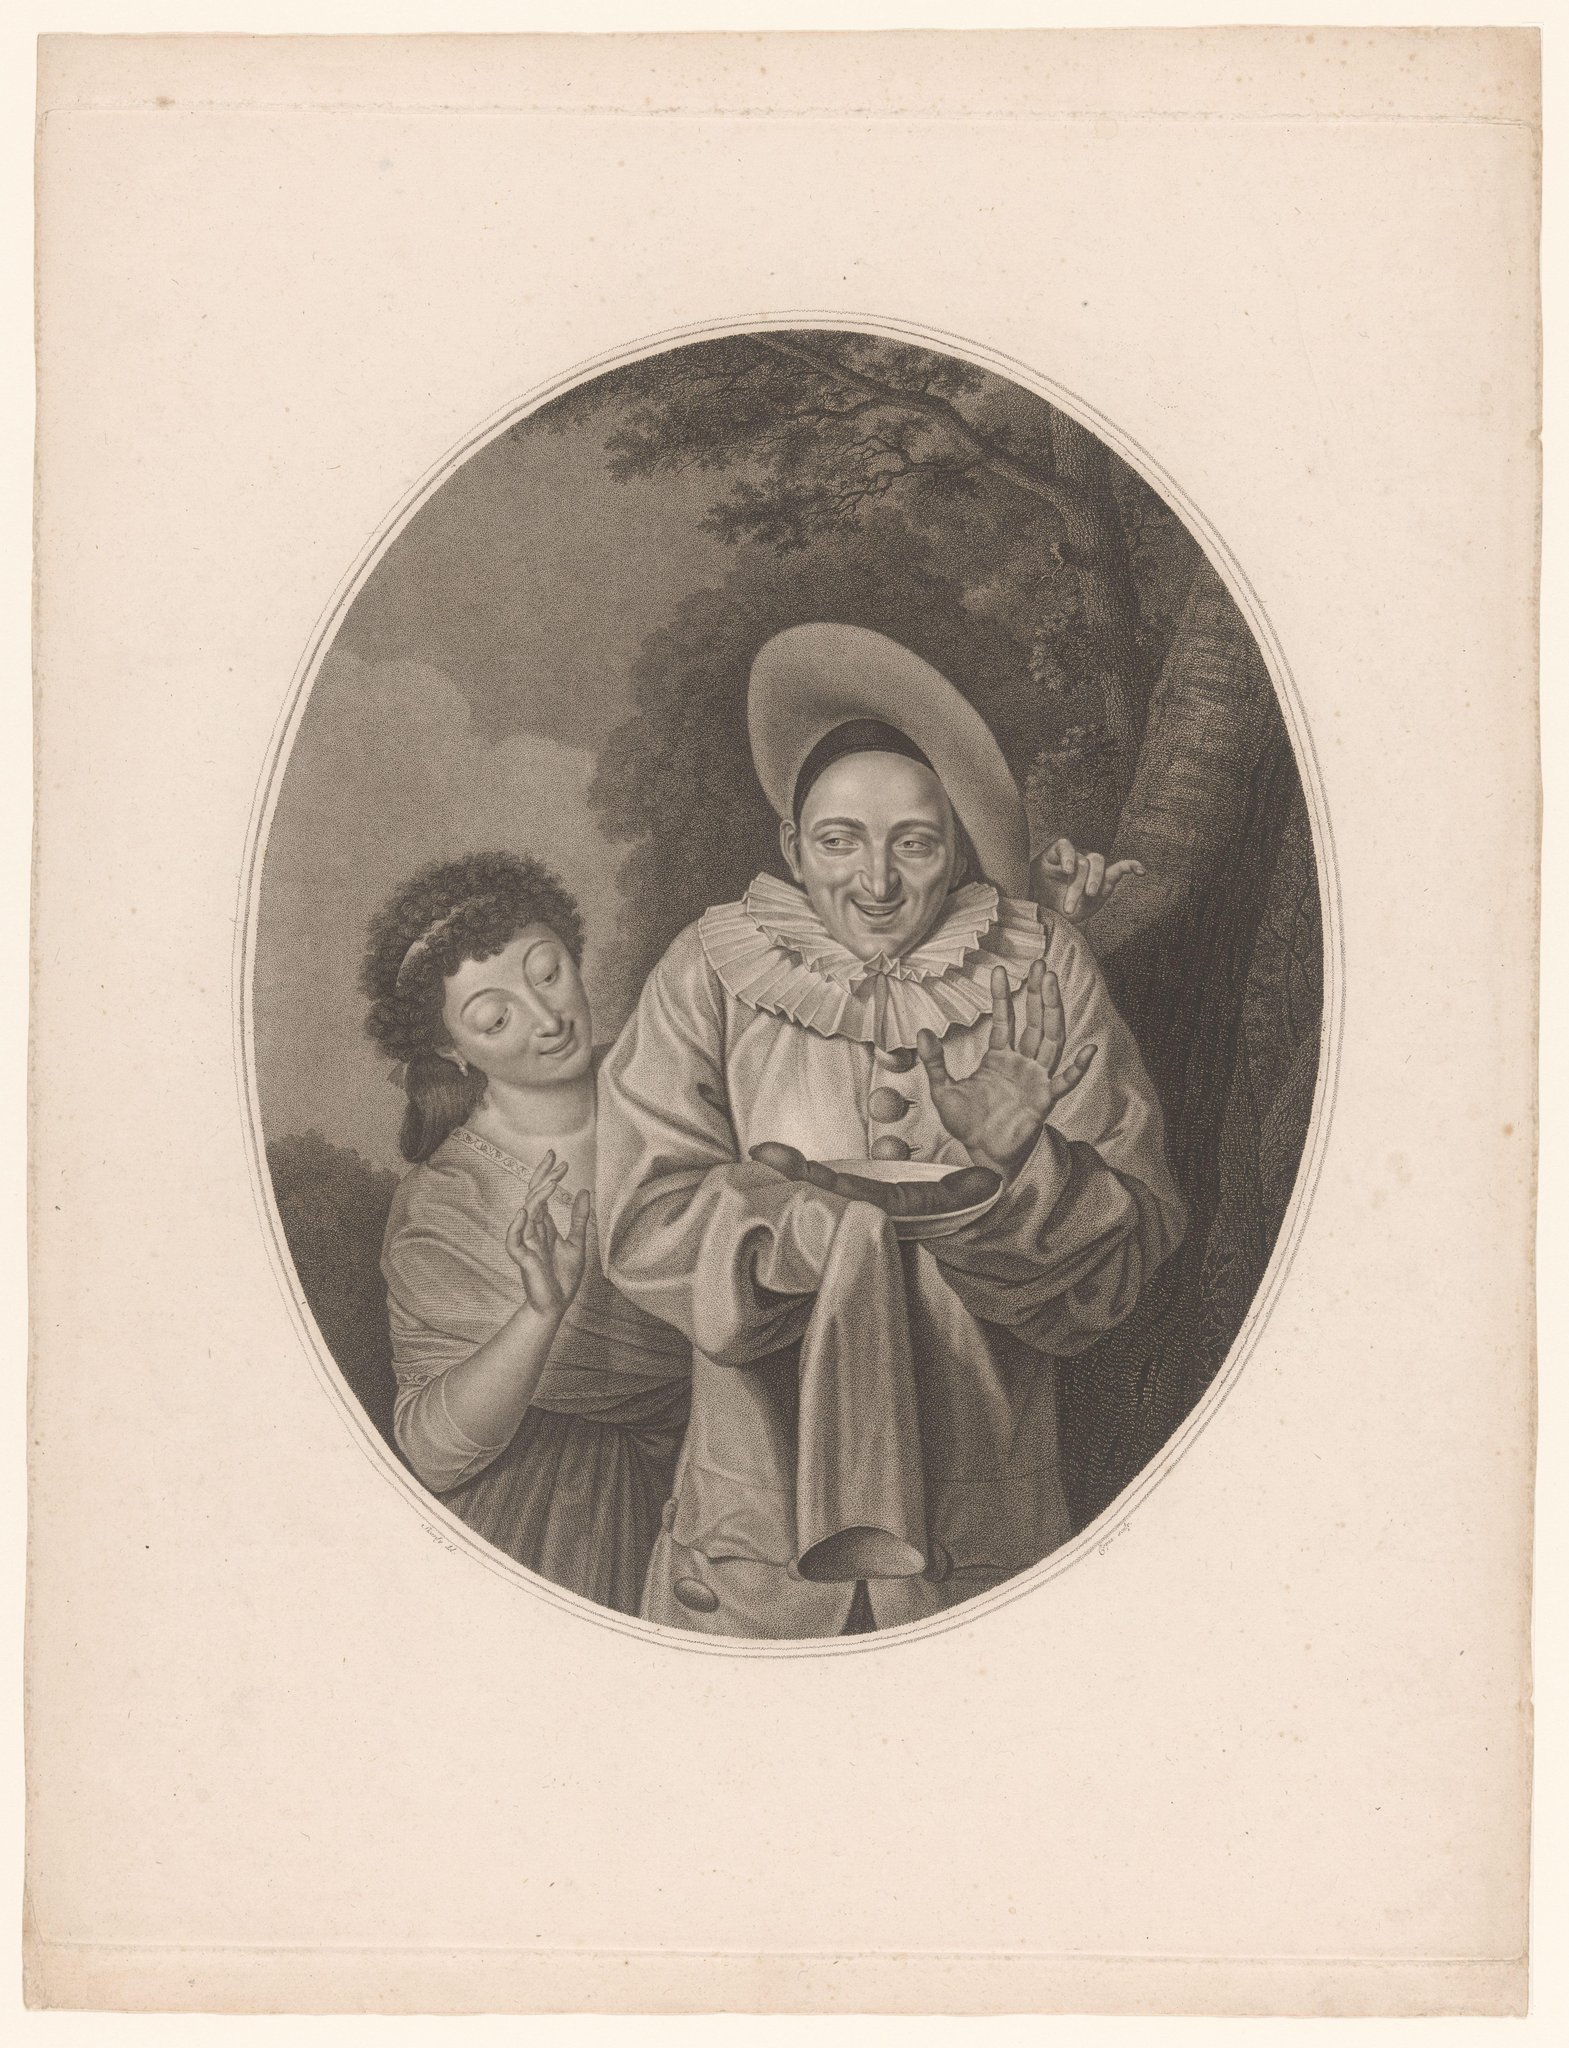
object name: print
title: Pierrot met worst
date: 1774-1799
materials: paper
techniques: stippling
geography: france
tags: types in 'commedia dell'arte': pierrot, sausage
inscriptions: collector's mark: Lugt 2228, collector's mark: Lugt 2760